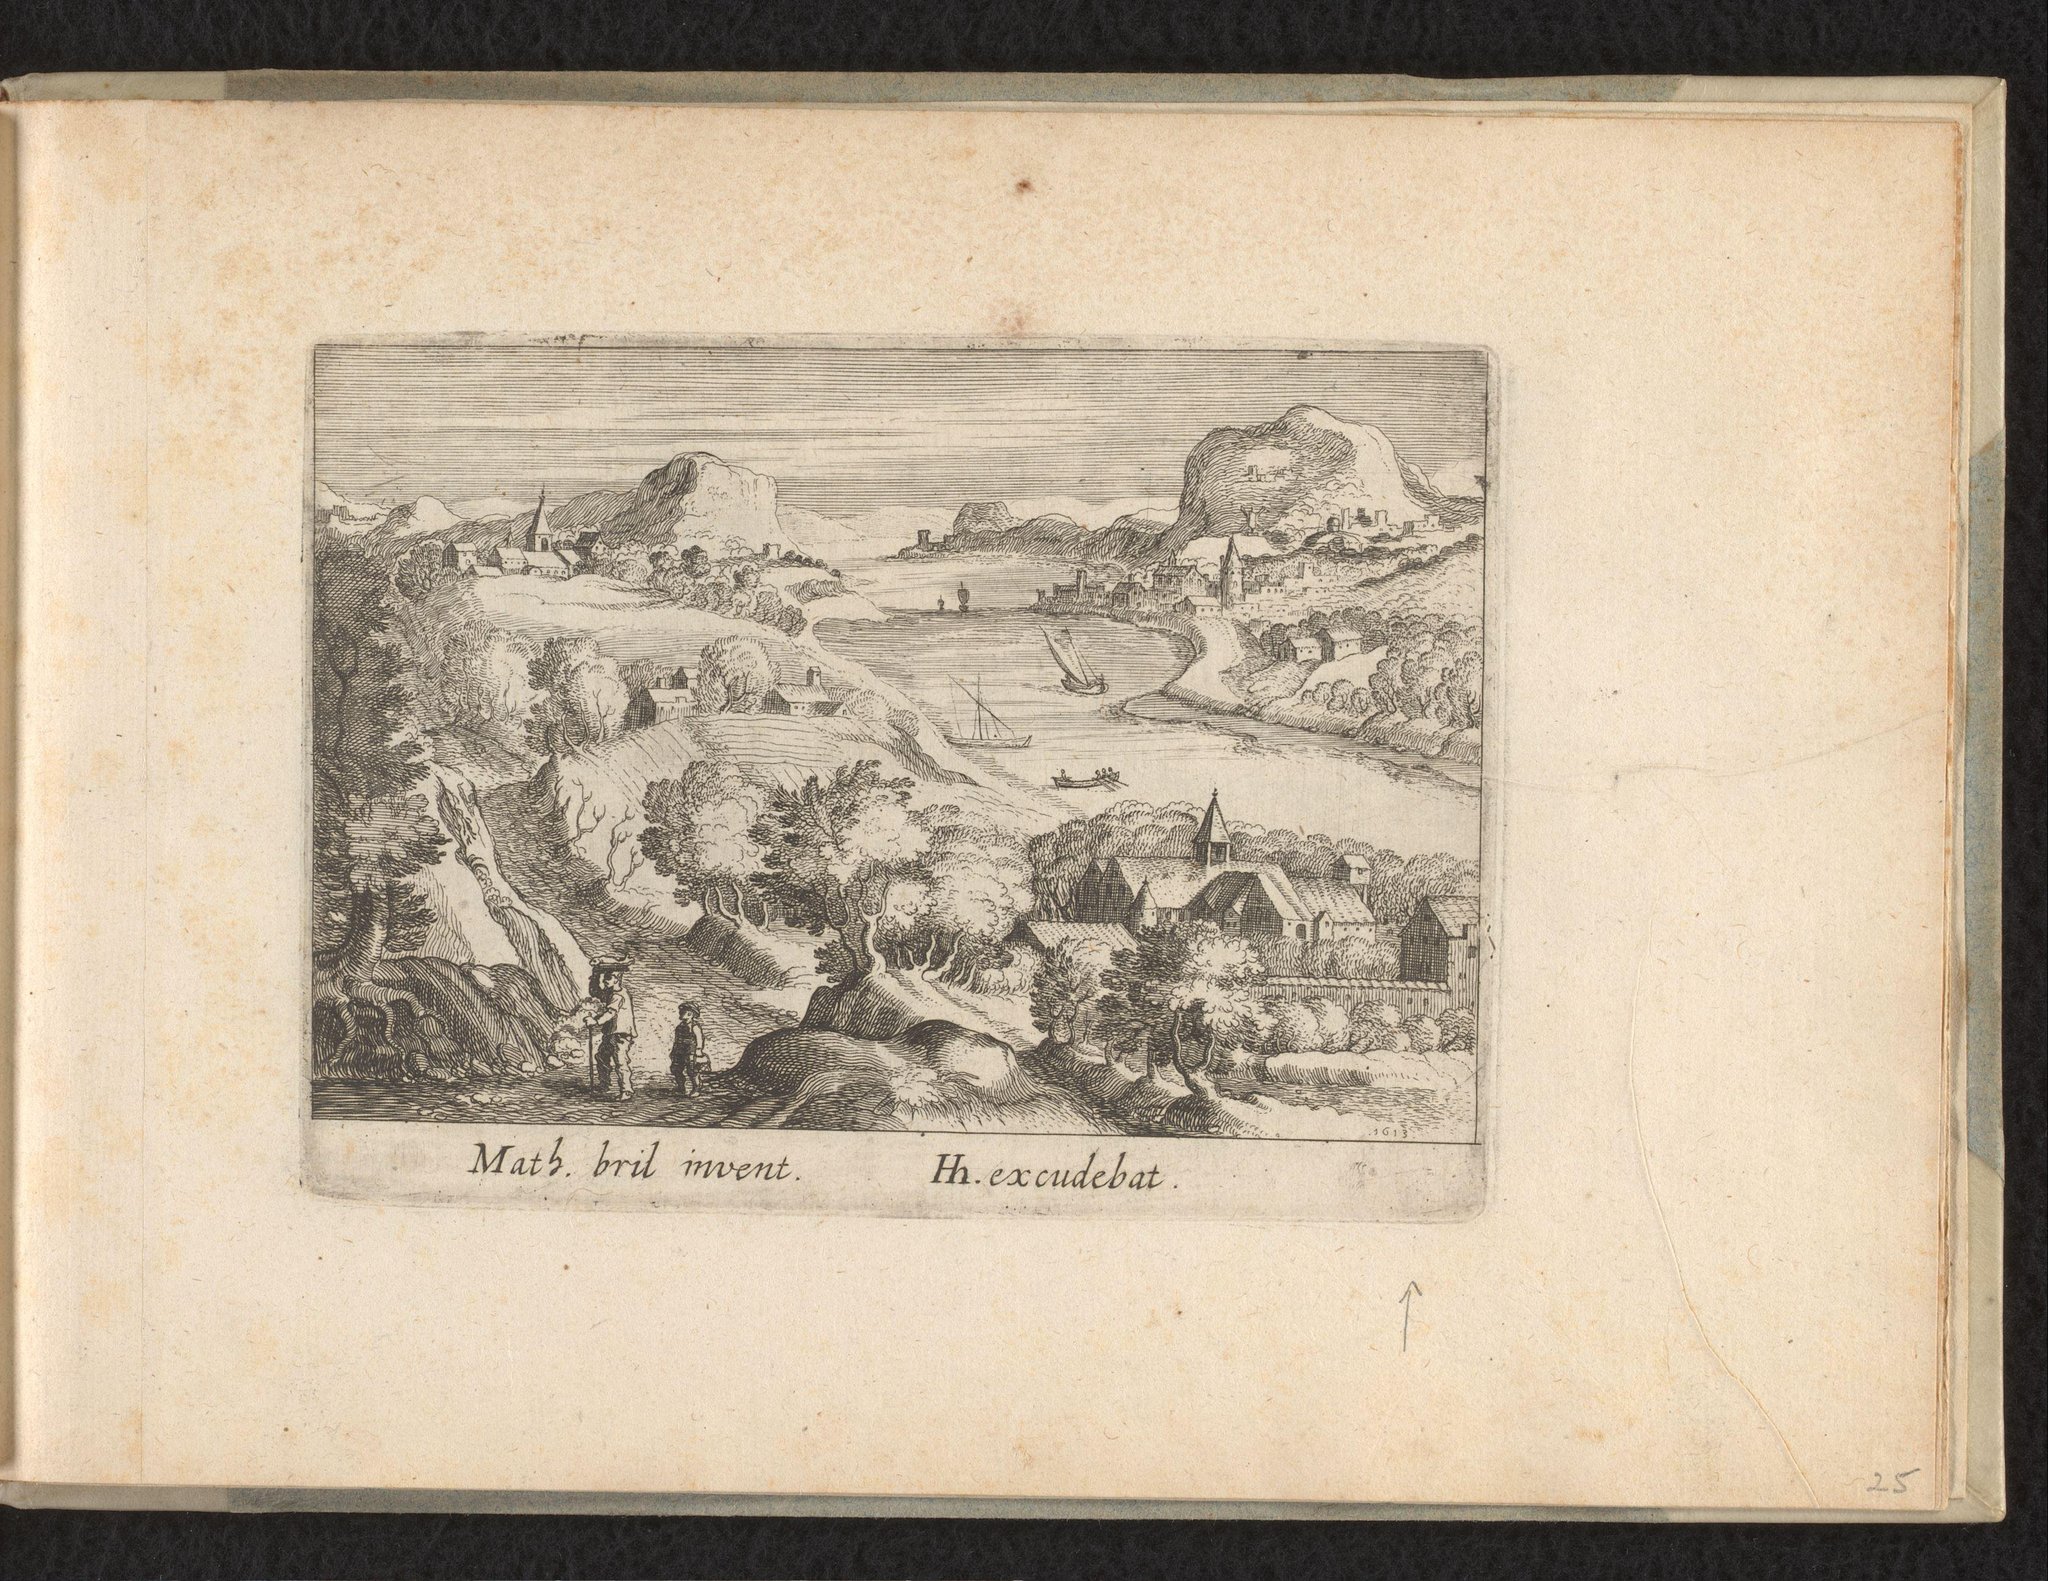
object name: print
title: Topographia Variarum Regionum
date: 1614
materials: paper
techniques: etching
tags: river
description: Door een heuvelachtig landschap stroomt een brede rivier waarin zeilbootjes. Verspreide huizen en kerktorens. Op de voorgrond een man met een mand met vis op zijn hoofd en een kind, lopend op een landweg.